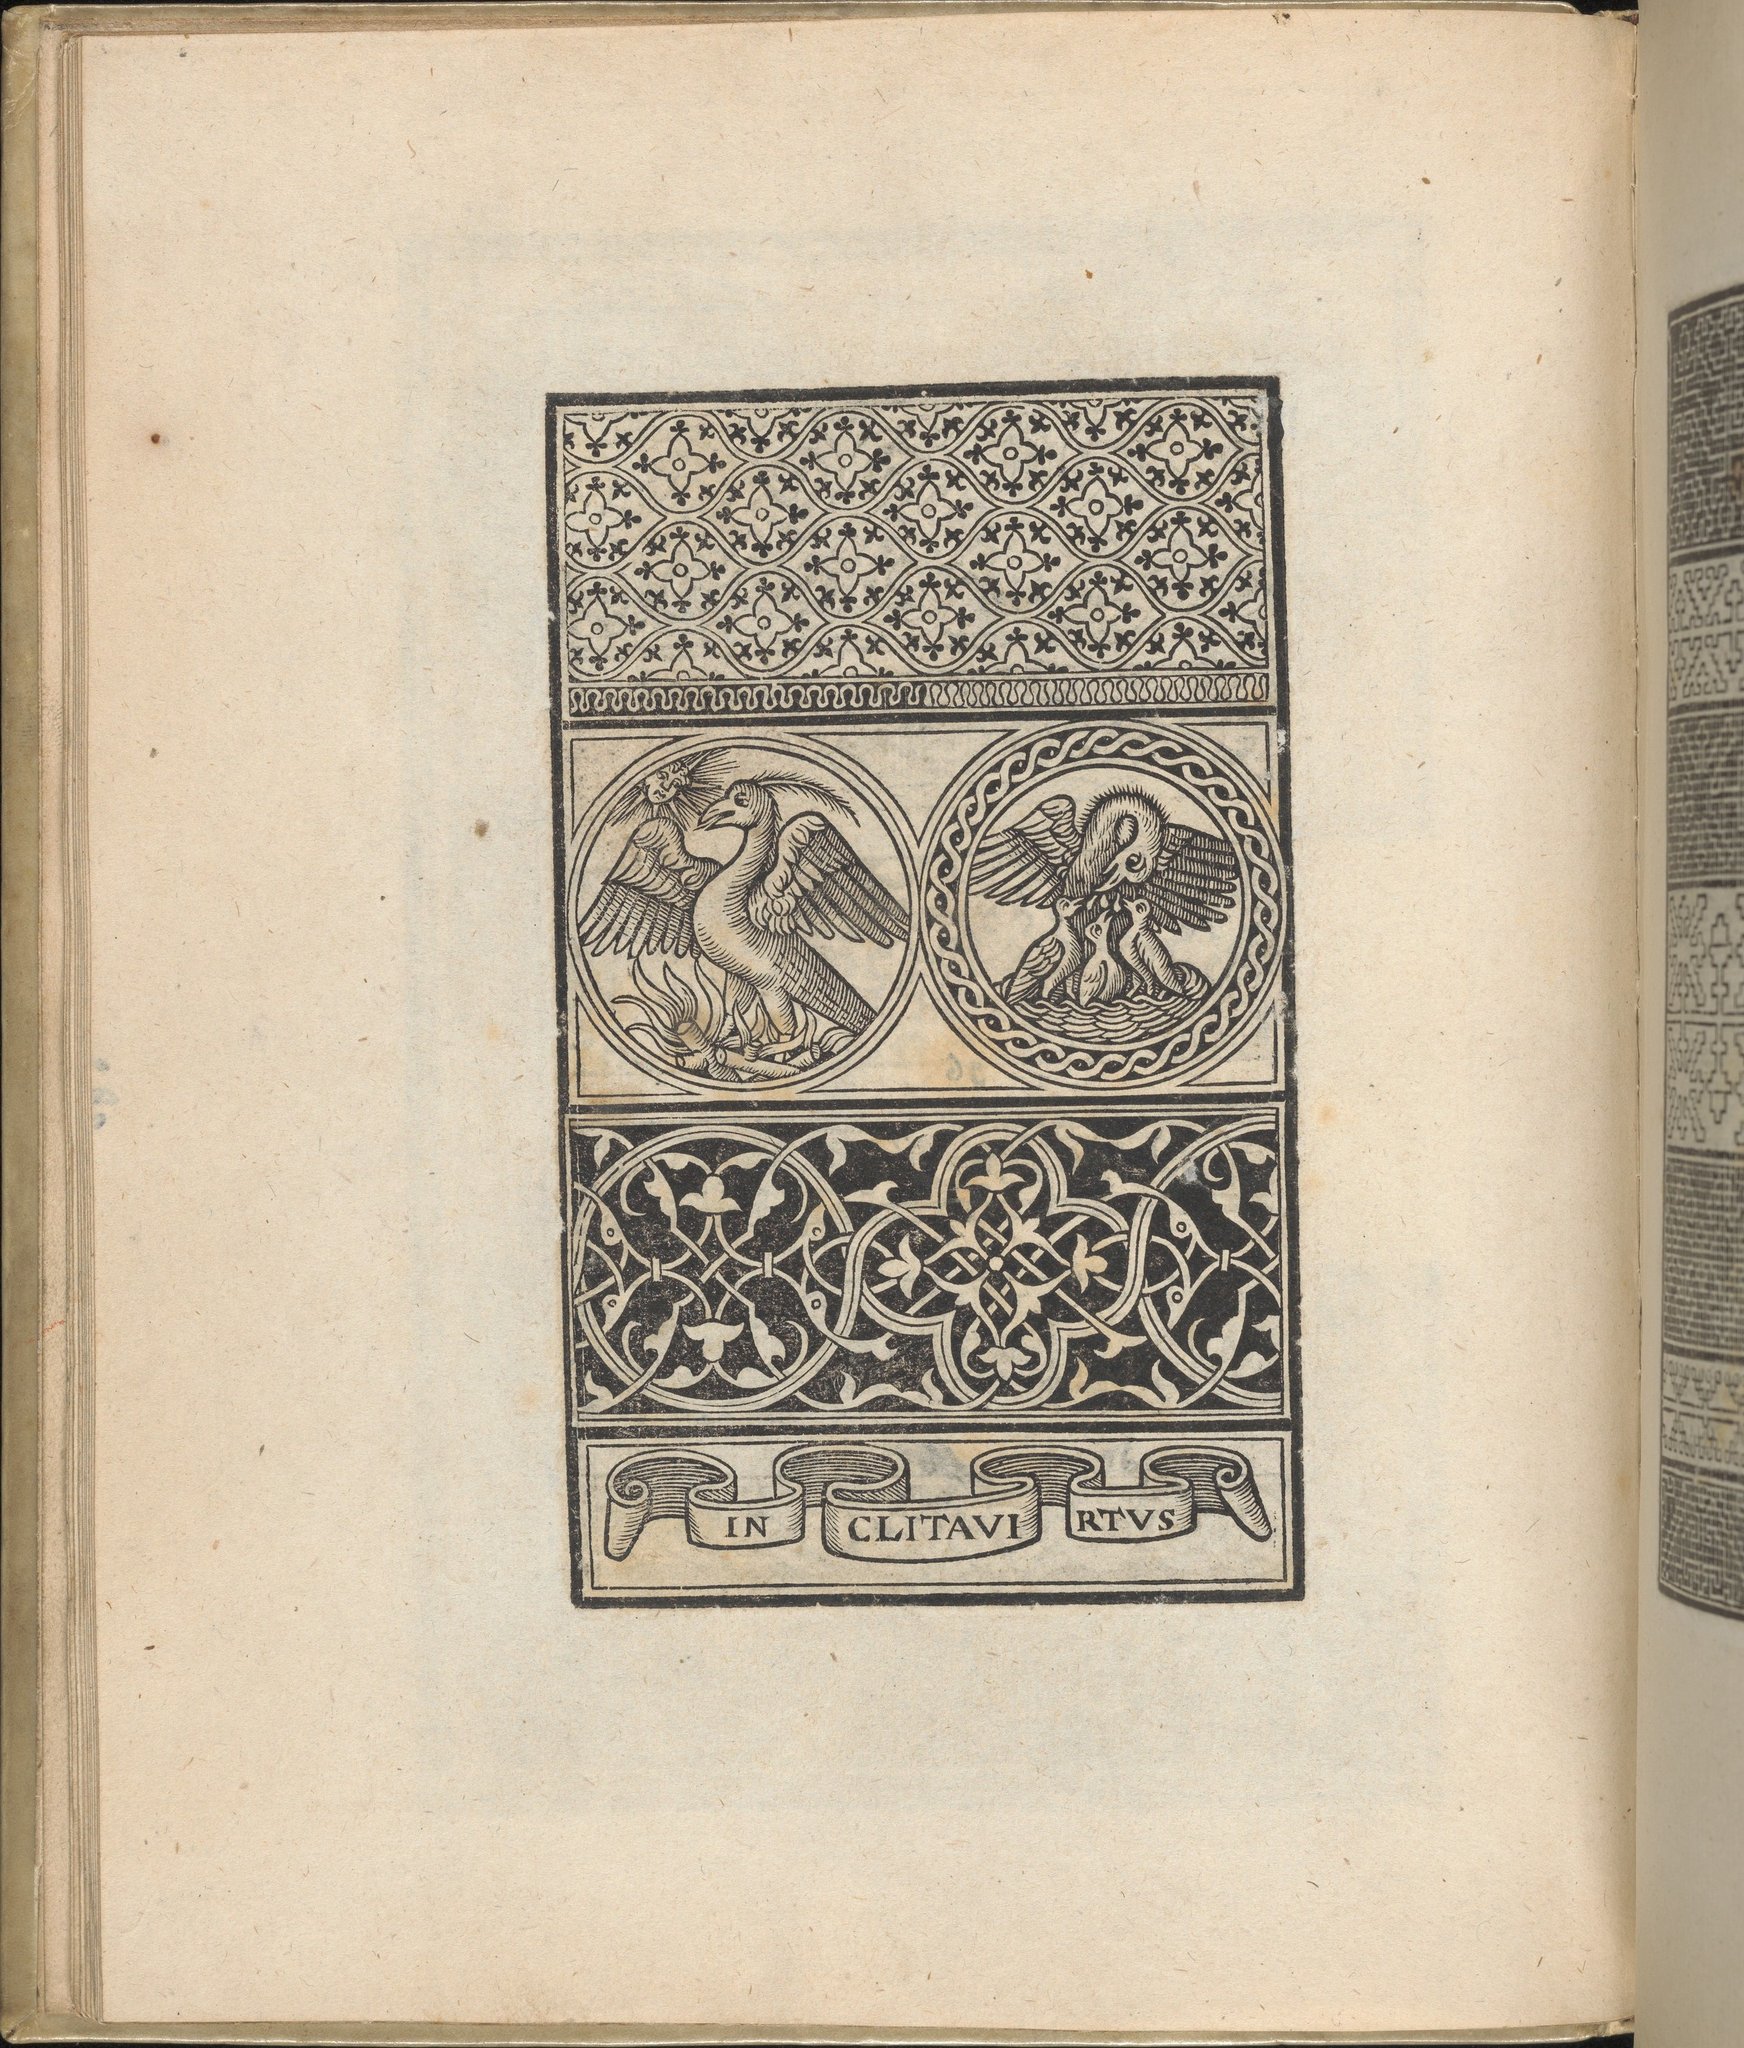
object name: book print ornament architecture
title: Trionfo Di Virtu. Libro Novo..., page 9 (verso)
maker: matteo pagano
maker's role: publisher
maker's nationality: italian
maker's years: 1515-1588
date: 1563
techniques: woodcut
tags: birds